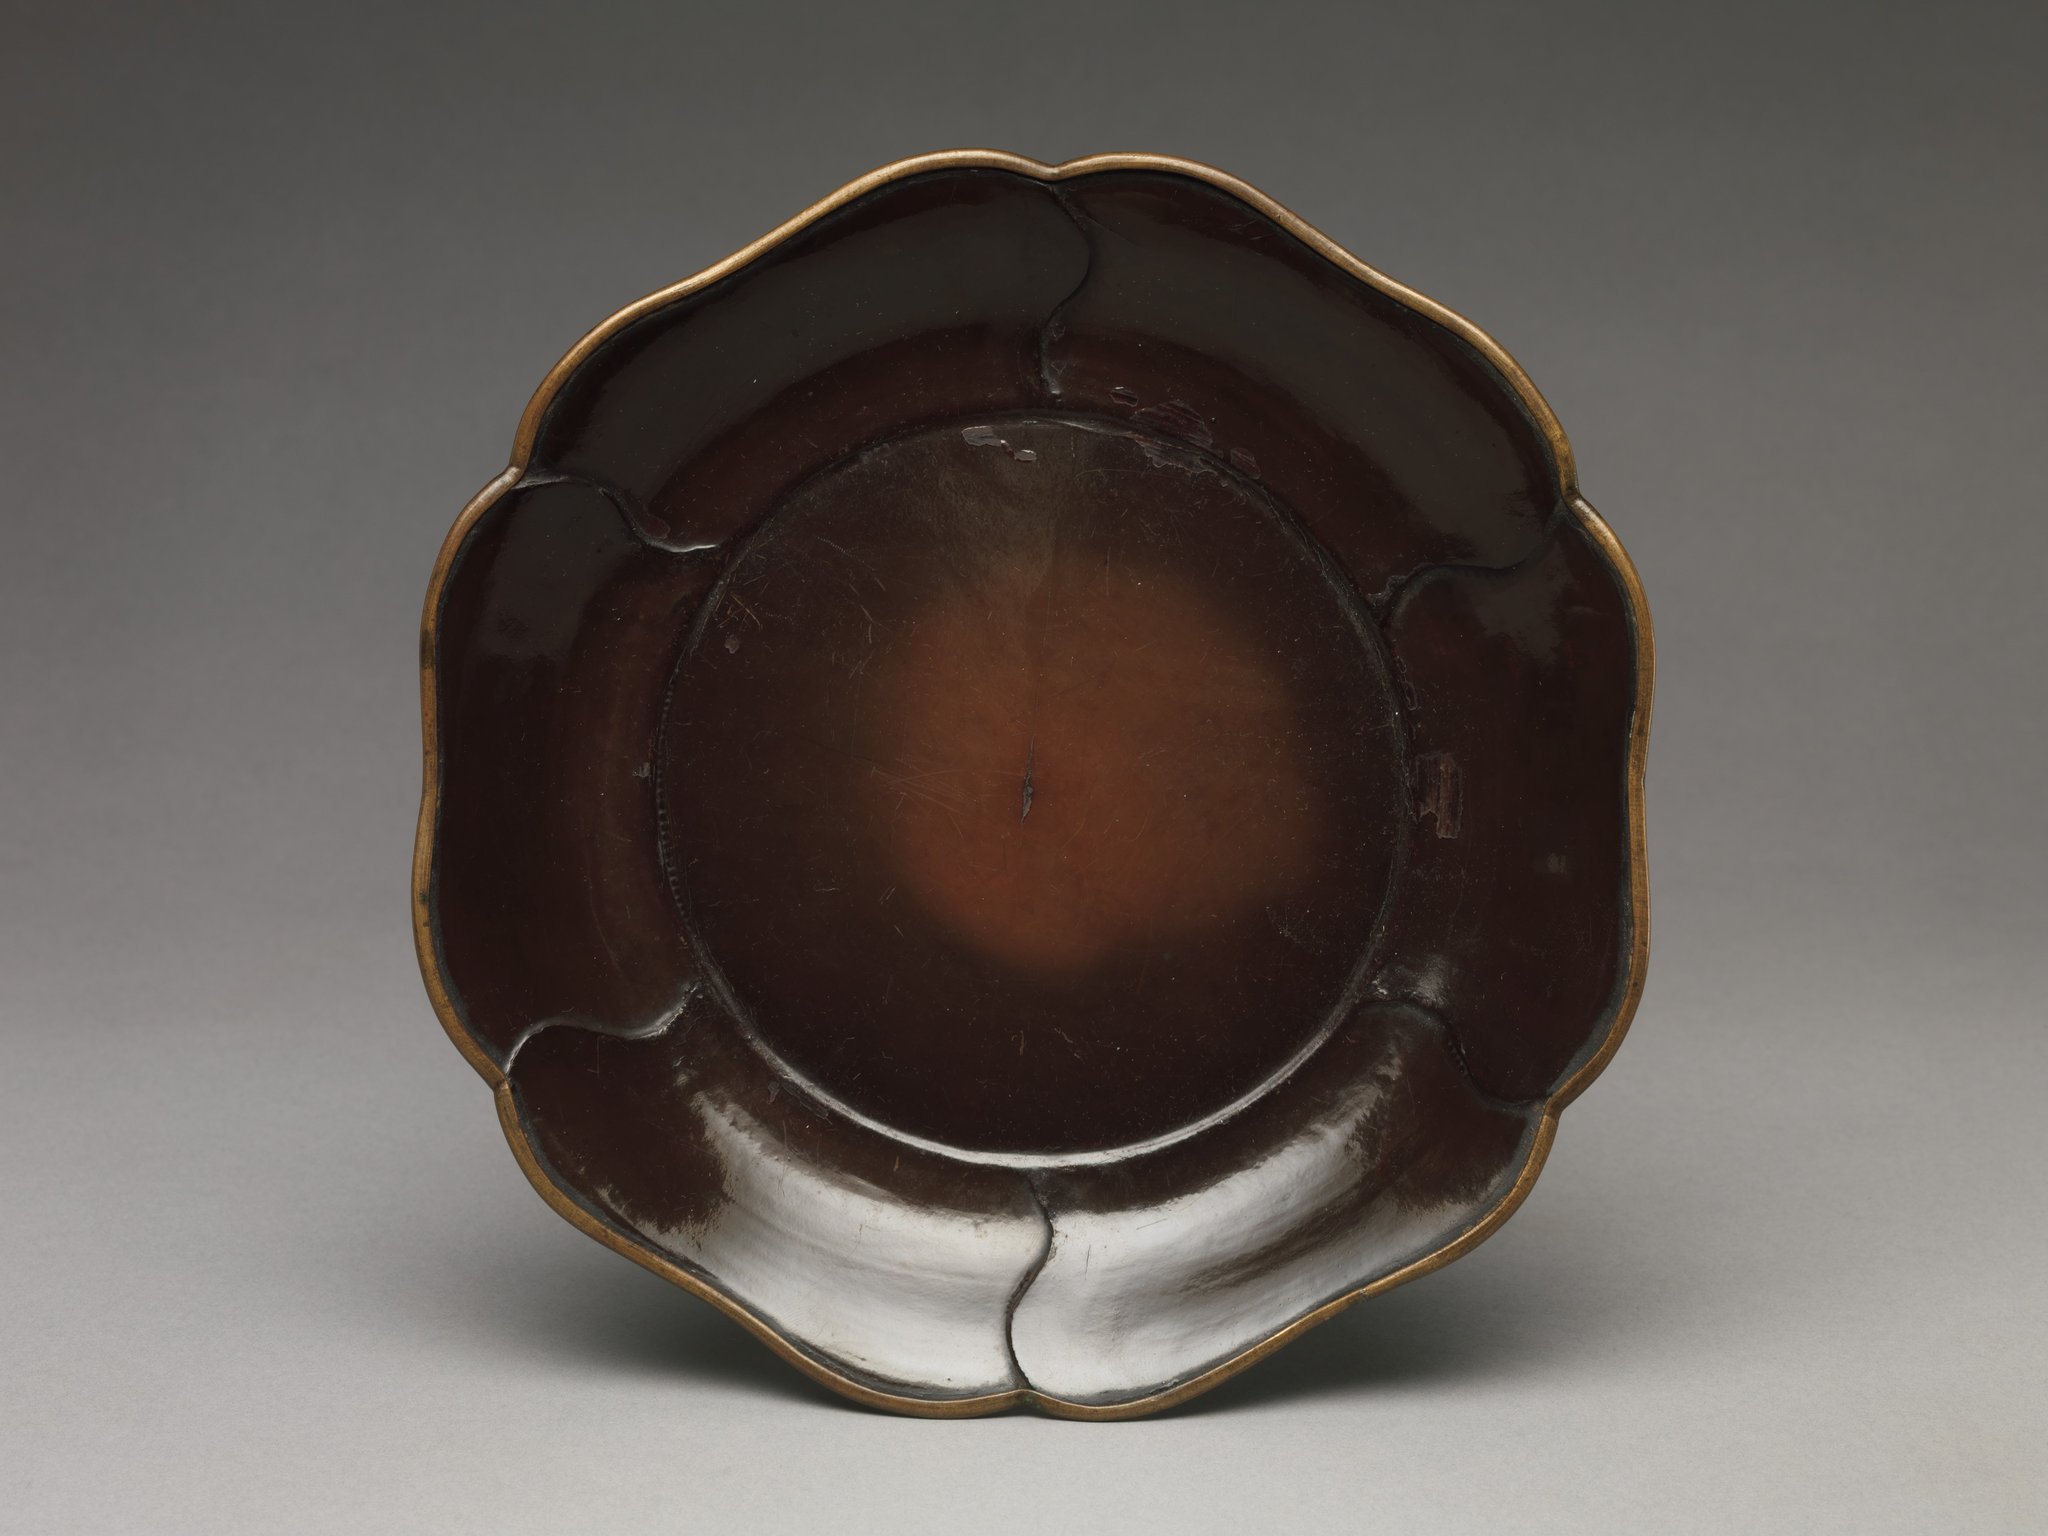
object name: dish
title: Dish with lobed rim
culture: chinese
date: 1201-1300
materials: lacquer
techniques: gilding